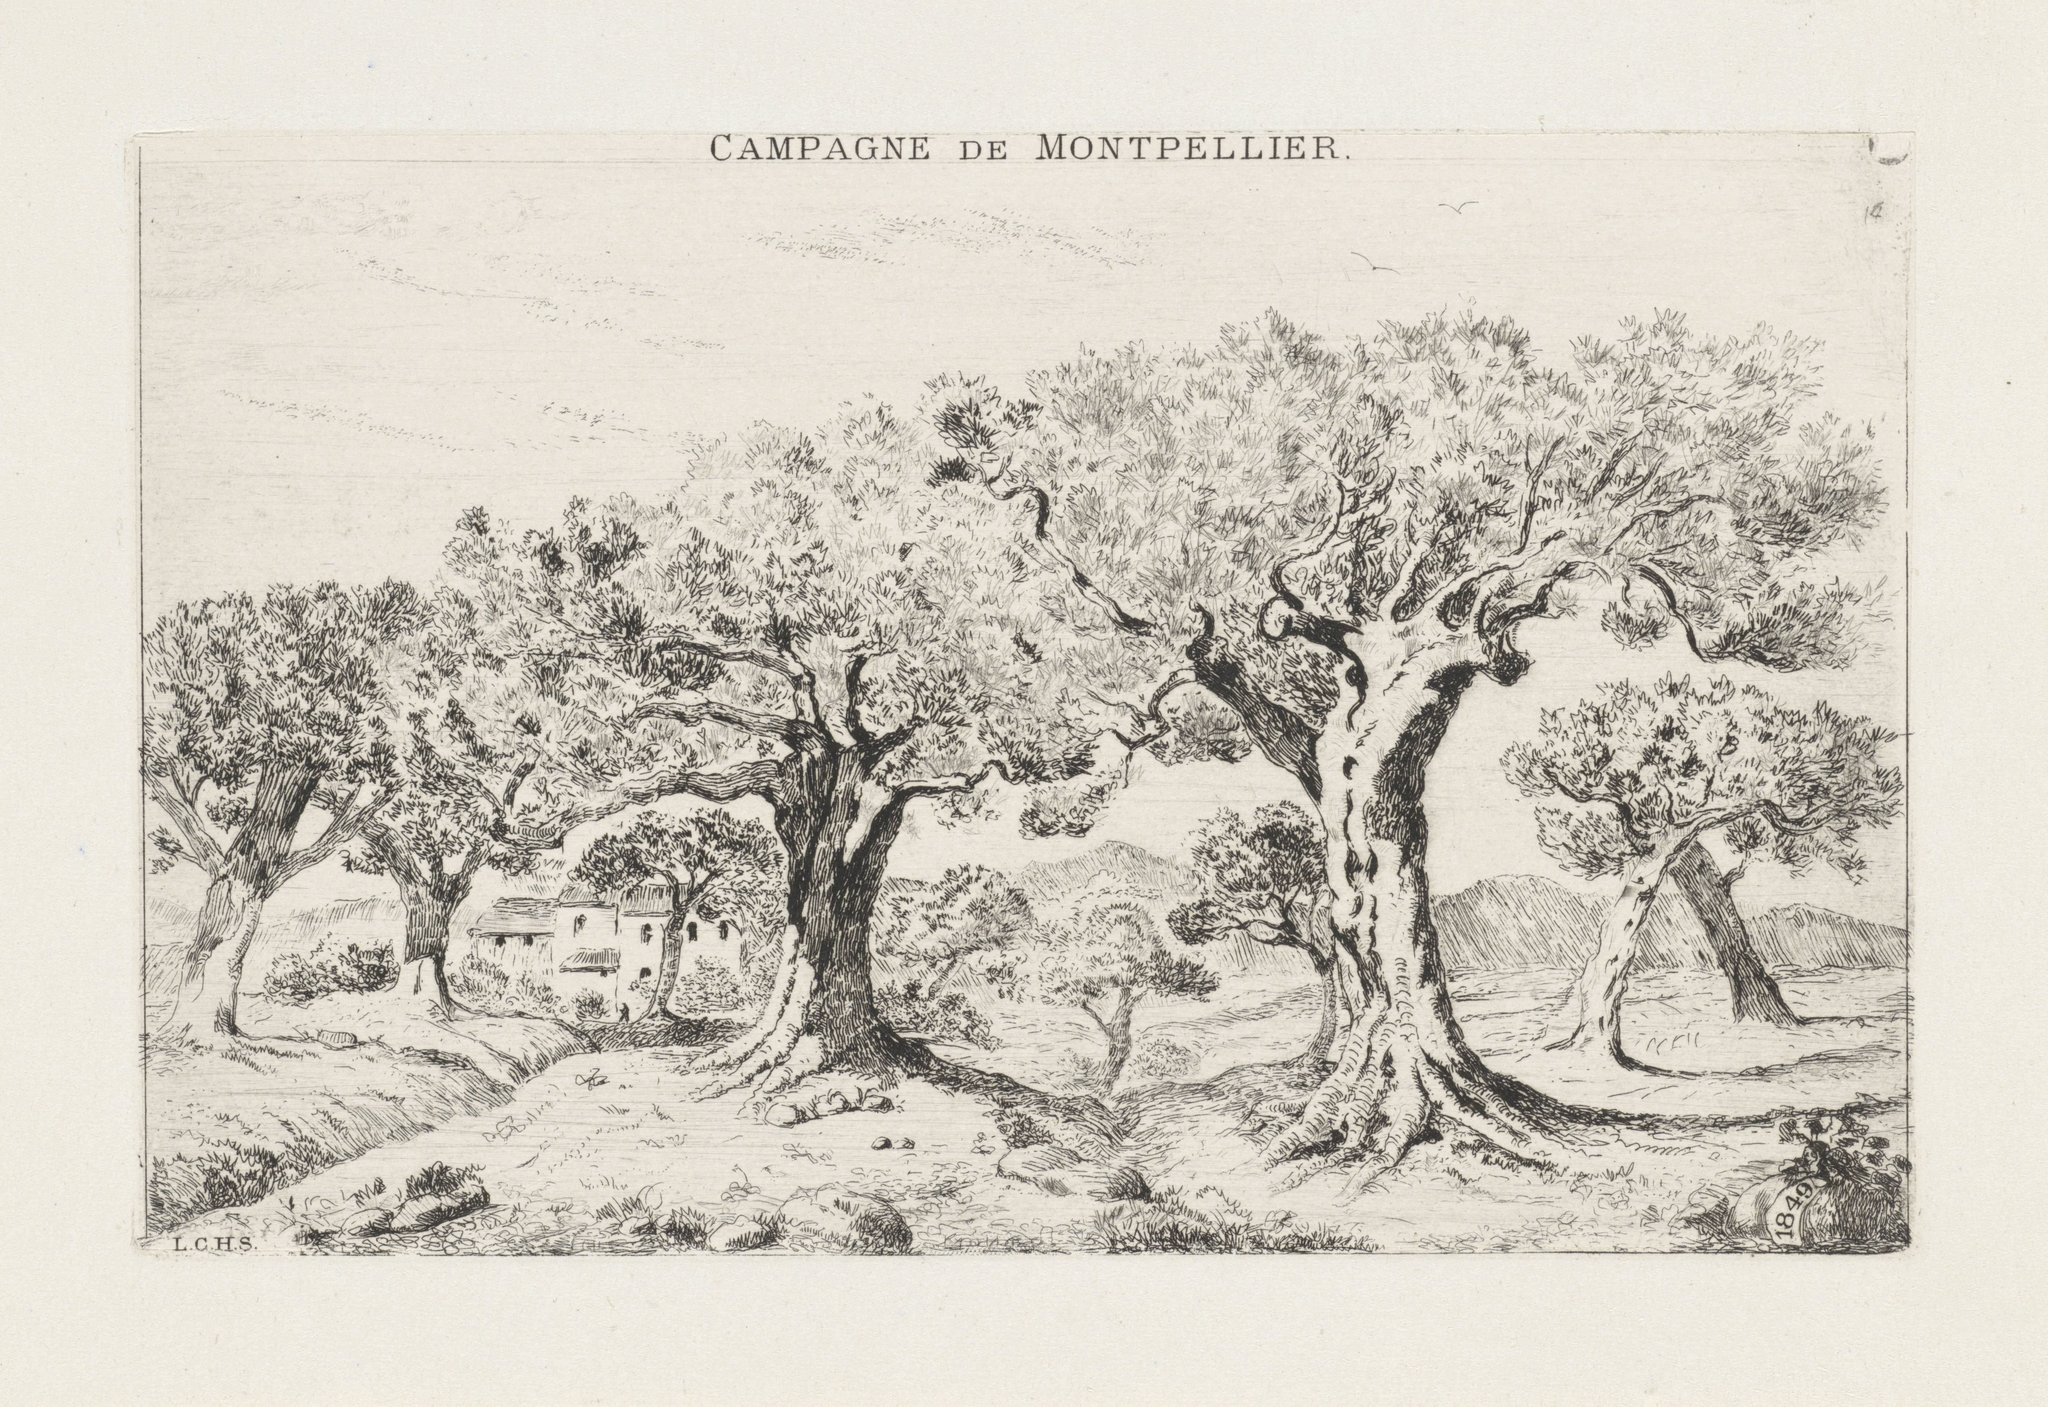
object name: print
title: Campagne de Montpellier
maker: louis charles hora siccama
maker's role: draughtsman, print maker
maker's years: 1807-1880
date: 1849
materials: paper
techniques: etching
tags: trees: olive-tree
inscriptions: collector's mark: Lugt 2228